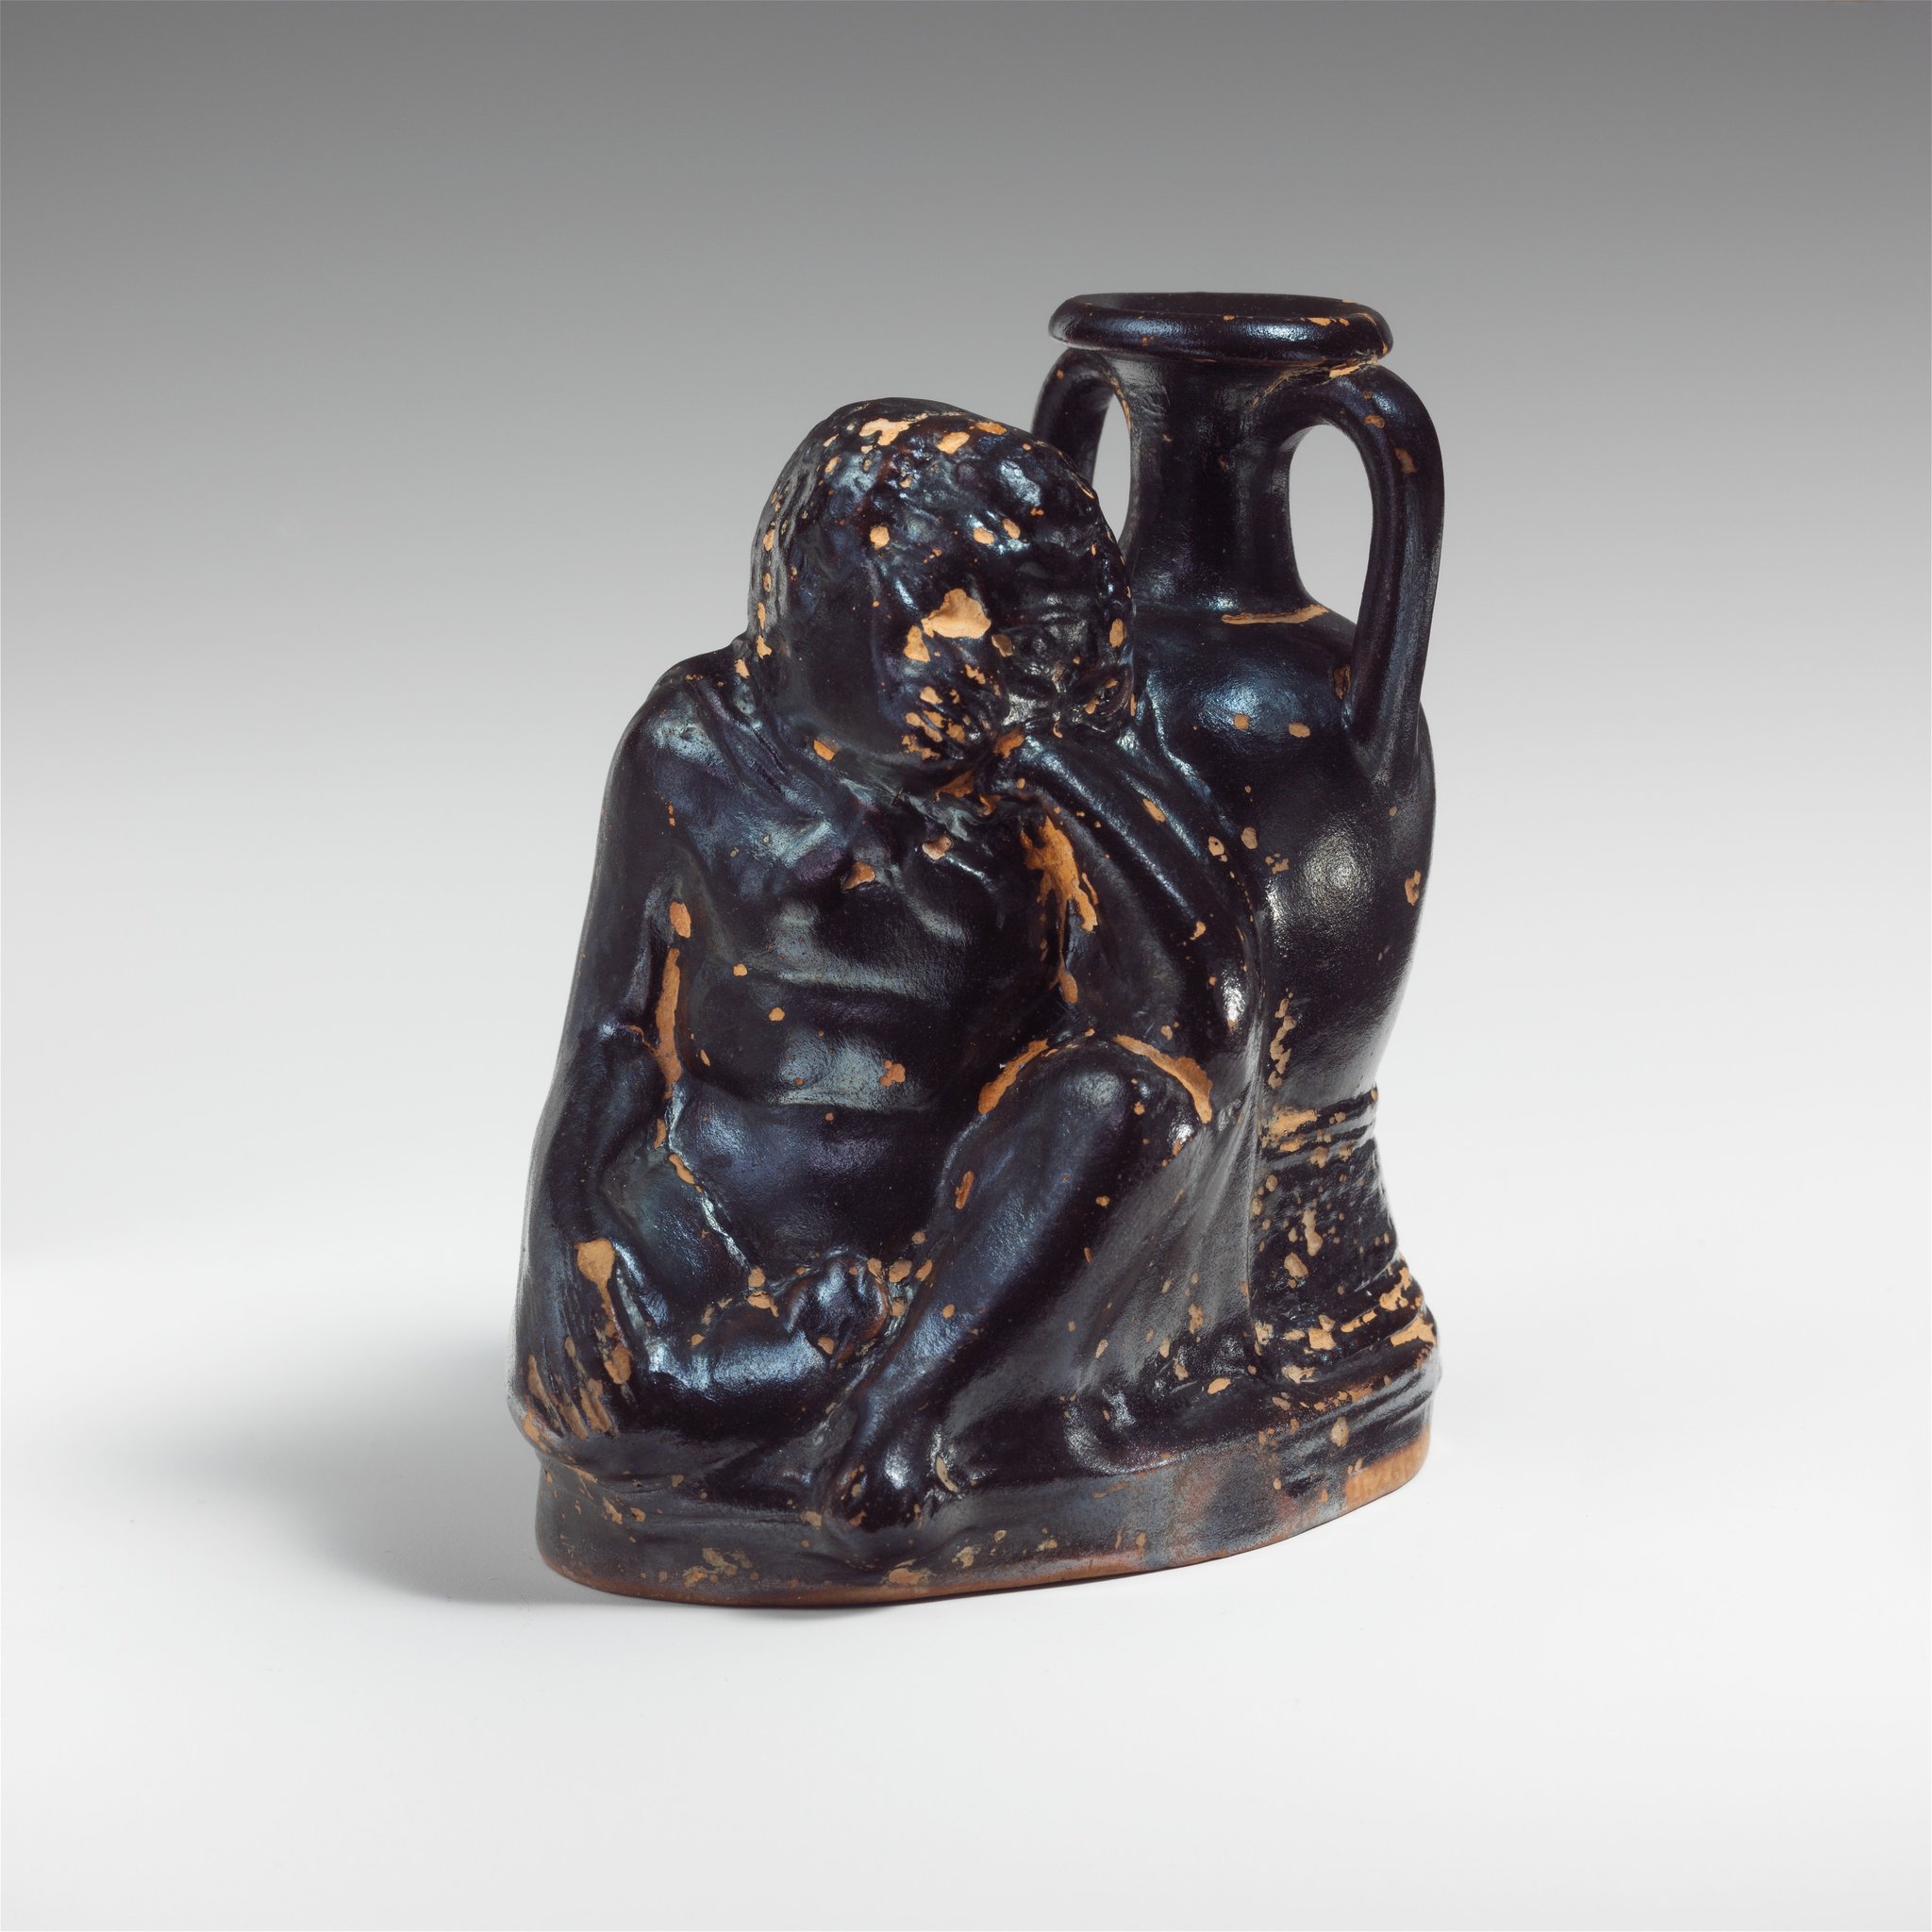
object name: guttus in the form of a sleeping boy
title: Terracotta askos (flask with a spout and handle)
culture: greek or south italian or campanian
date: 400-301 BCE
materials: terracotta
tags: boys